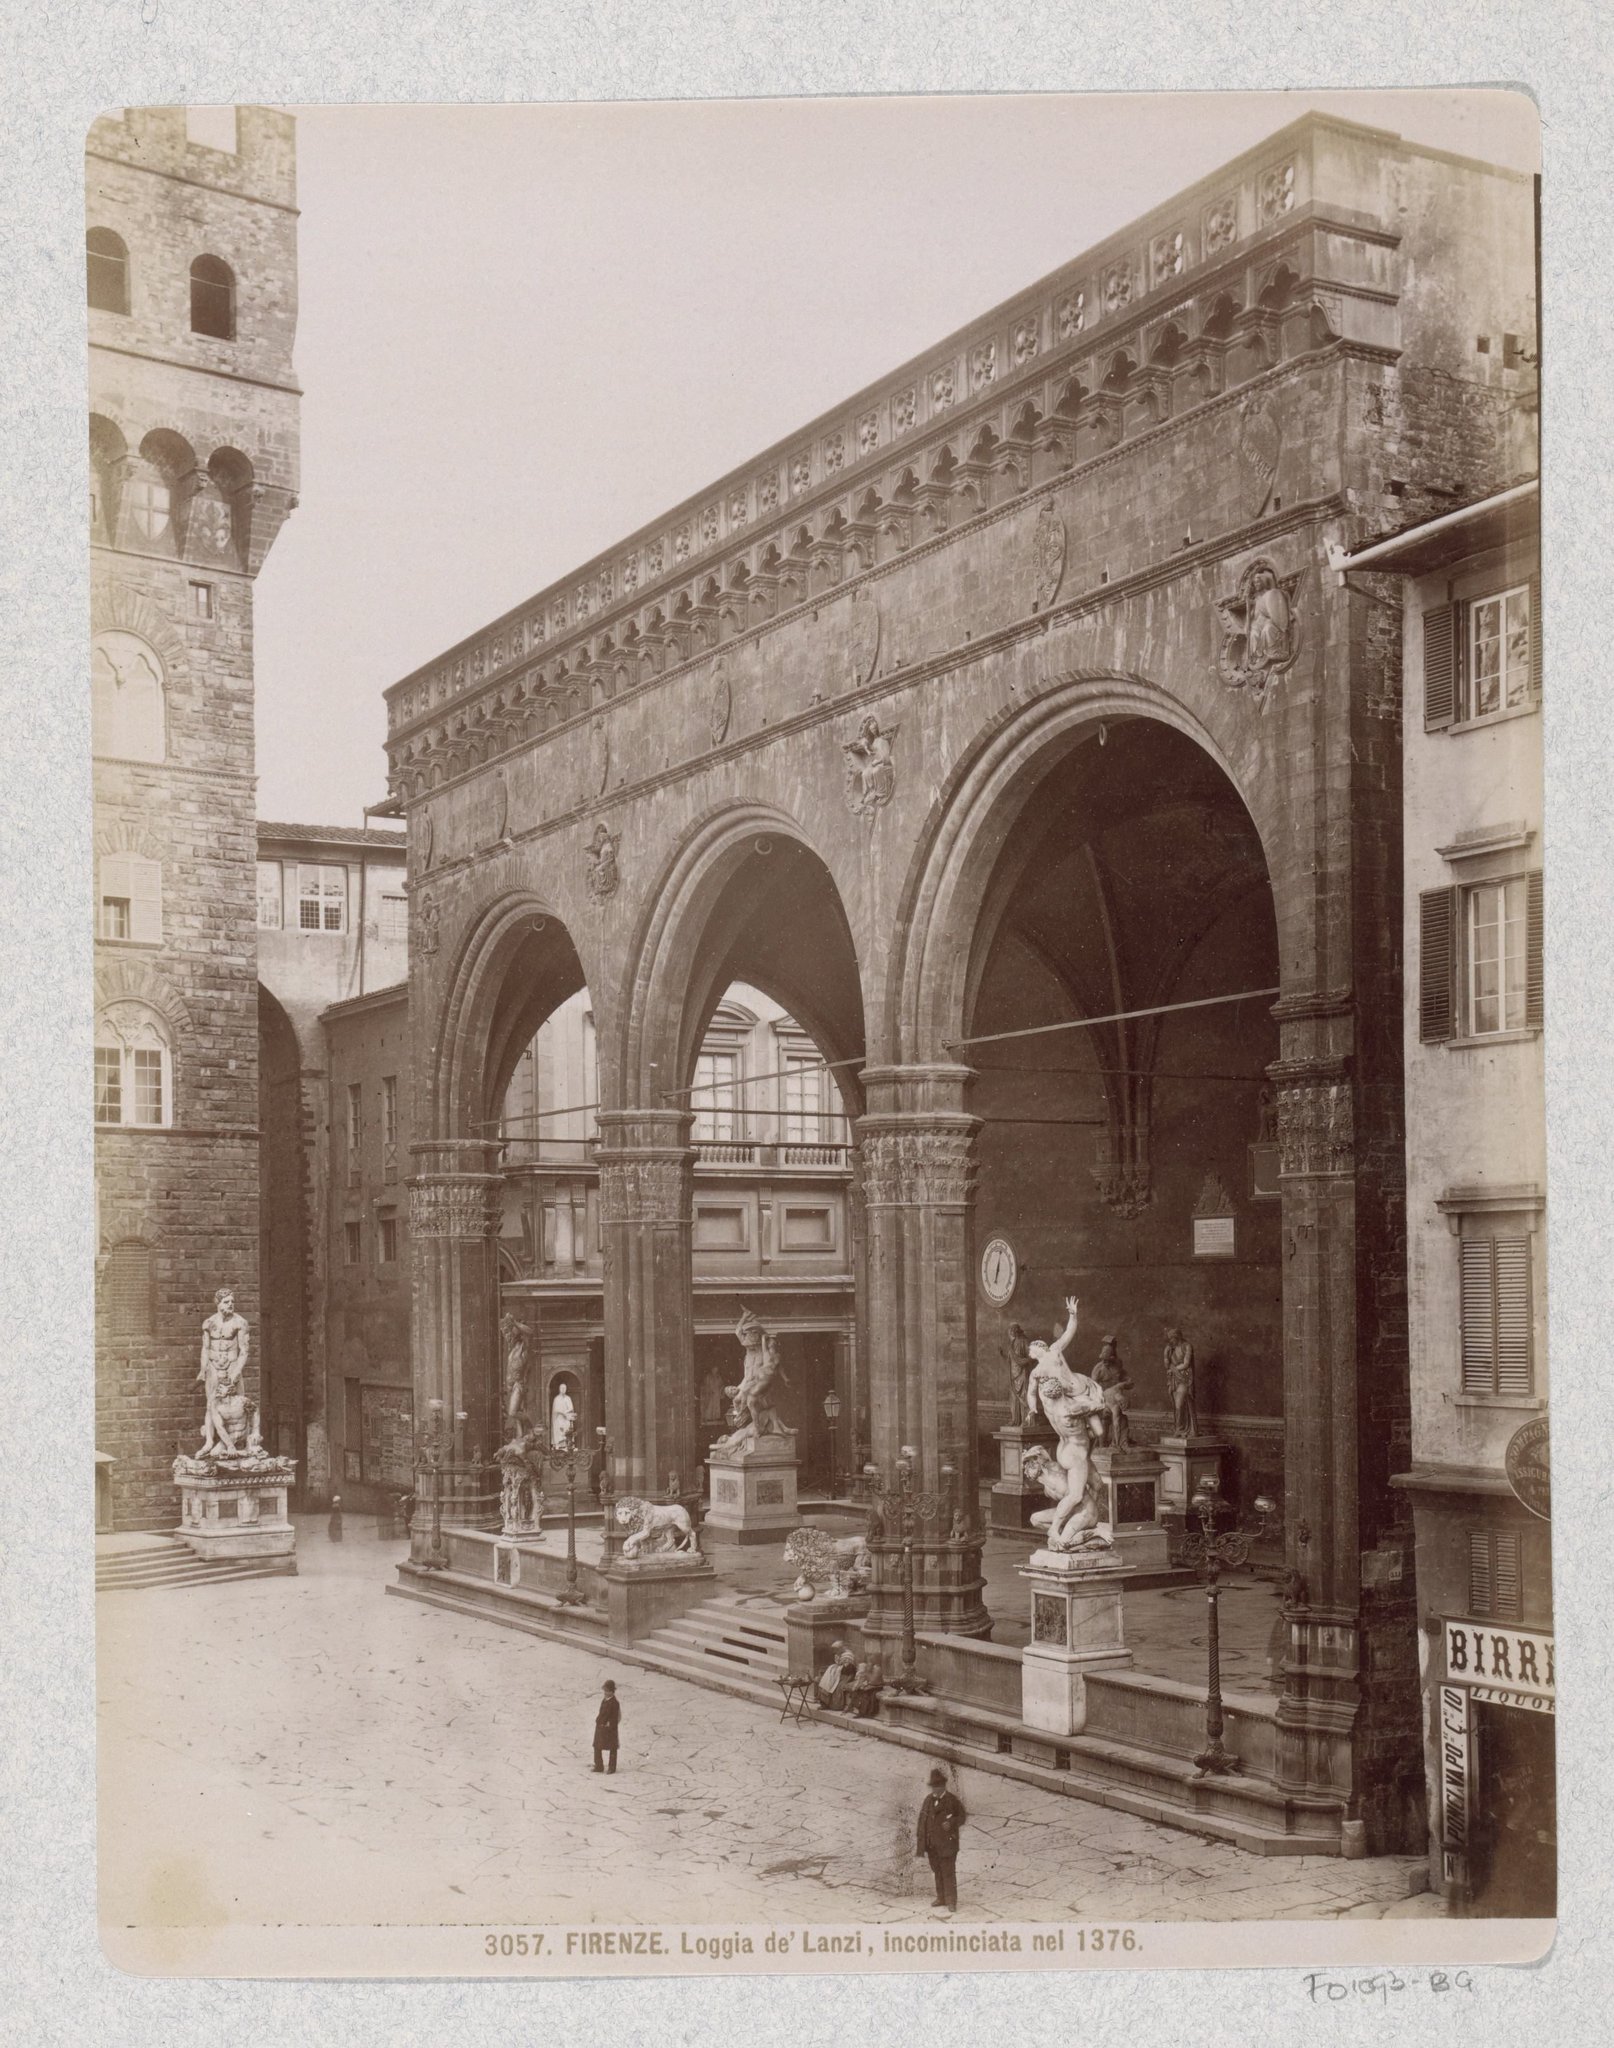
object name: photograph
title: Loggia dei Lanzi in Florence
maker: Anonymous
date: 1870-1890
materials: paper, photographic support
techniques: albumen print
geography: florence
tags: loggia, verandah, porch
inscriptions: negative number: ‘3057’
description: Onderdeel van Reisalbum met foto's van bezienswaardigheden in Genua, Florence en Venetië.